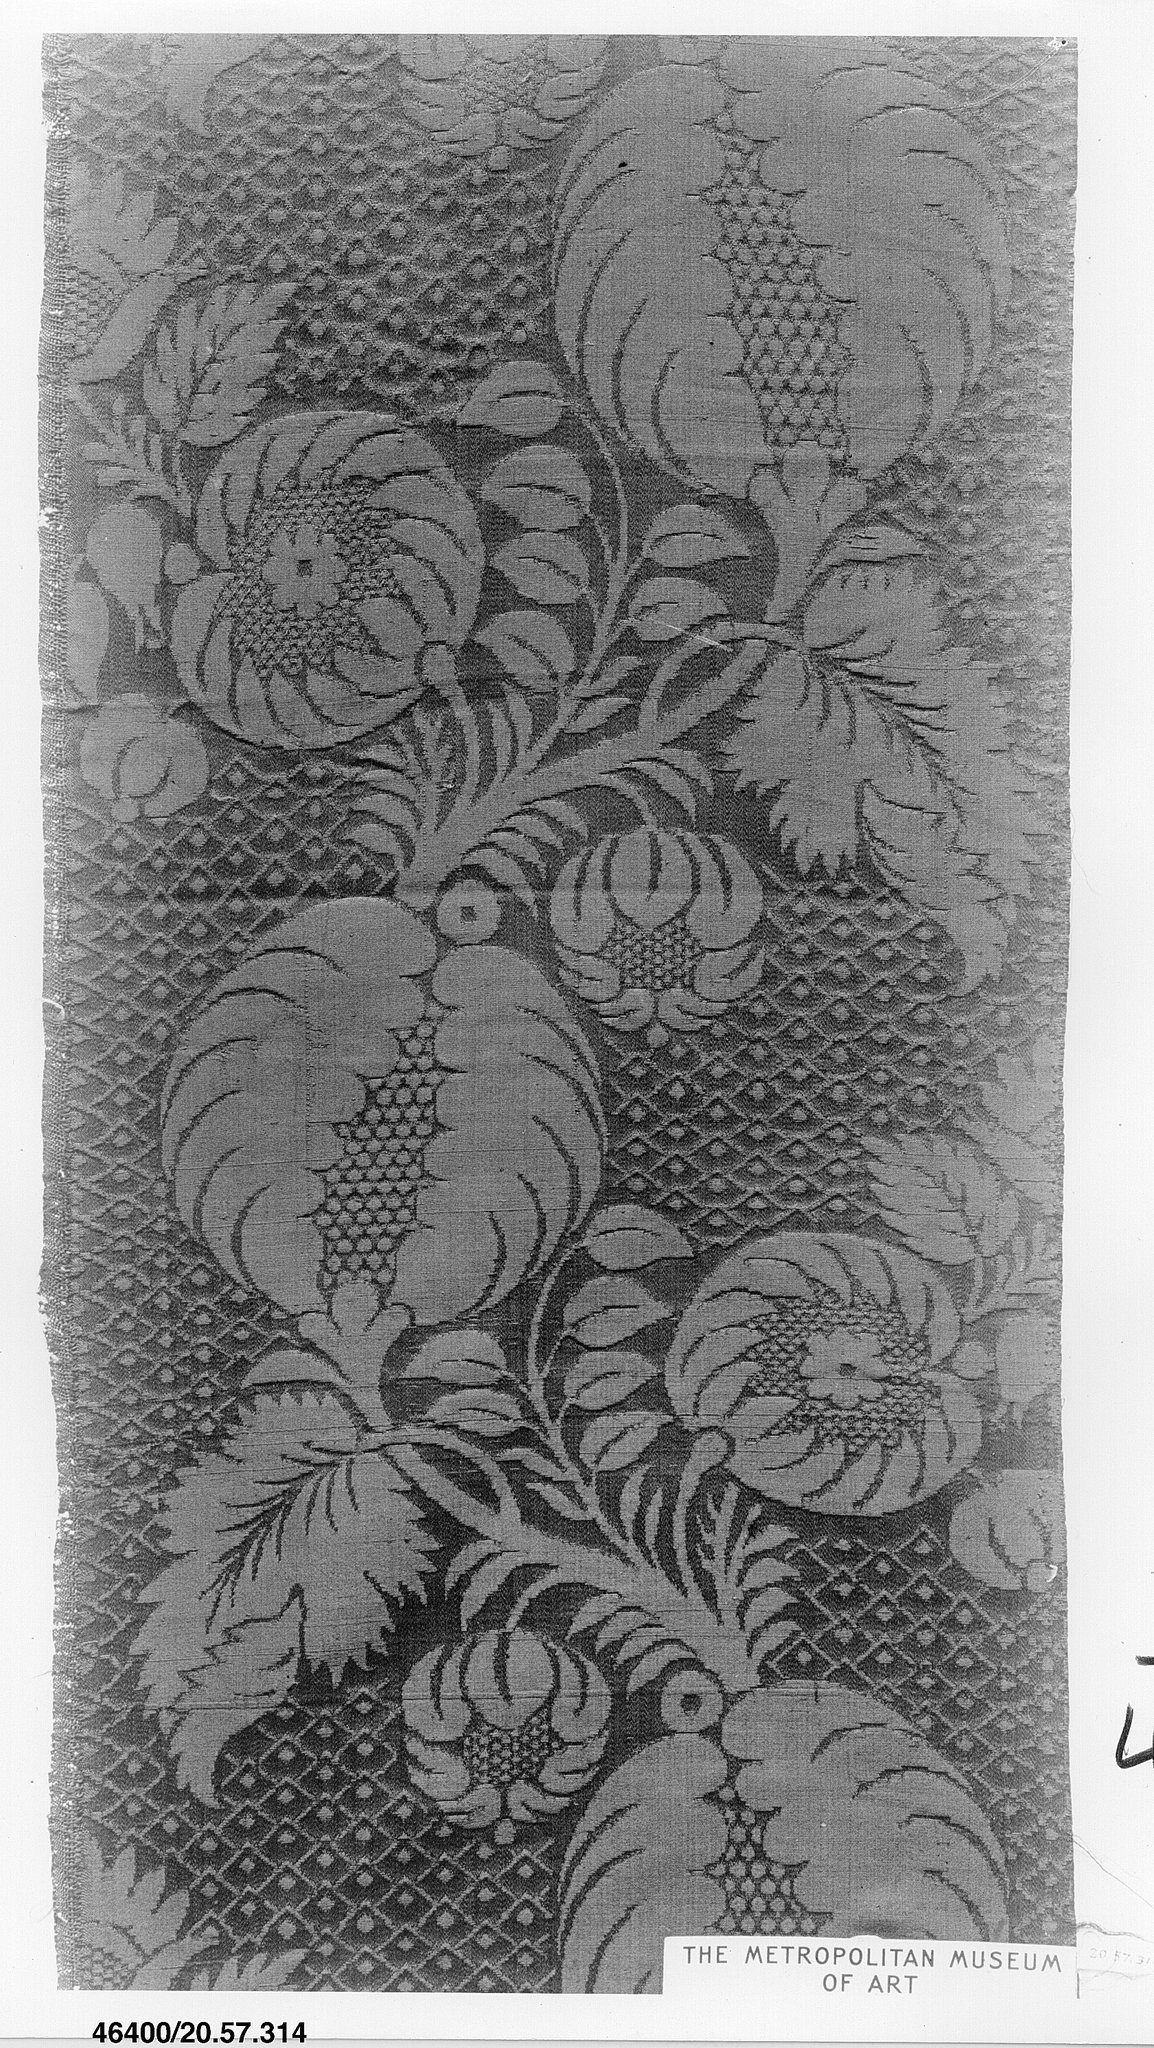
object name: piece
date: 1730-1735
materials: silk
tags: flowers,leaves